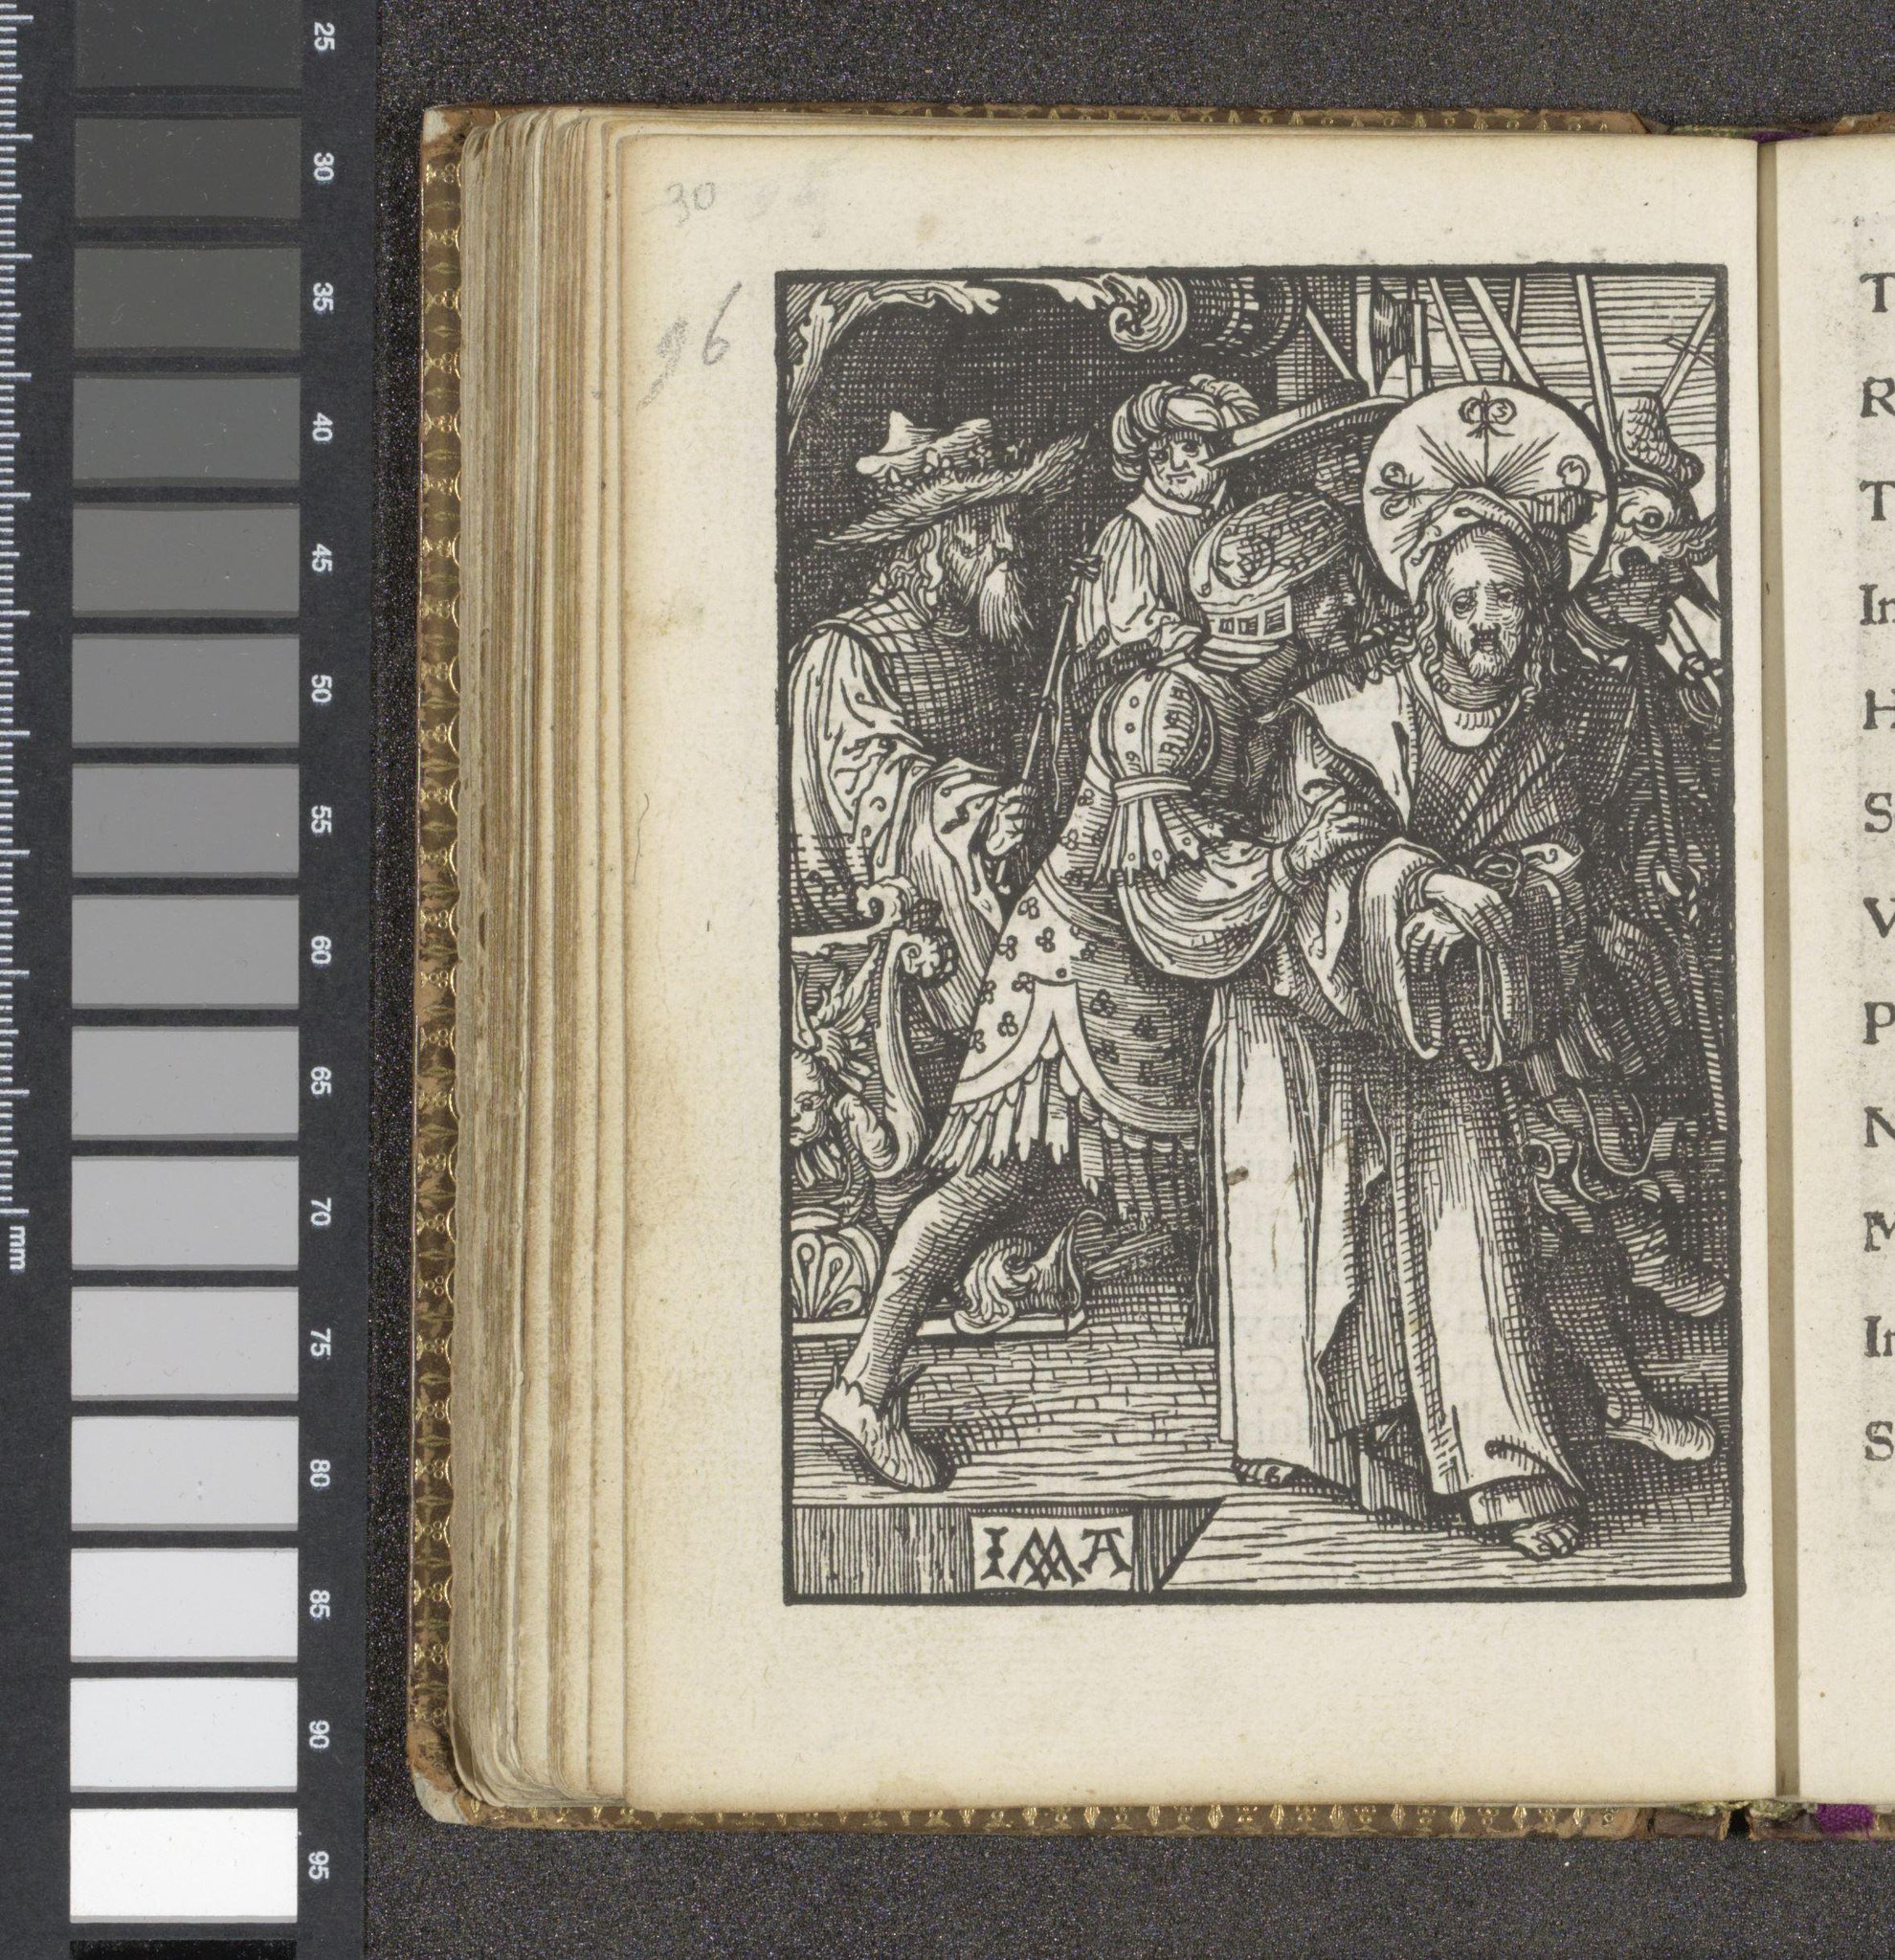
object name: book illustration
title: Christus weggeleid van Herodes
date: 1523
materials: paper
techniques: woodcut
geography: amsterdam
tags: christ before king herod; sometimes a gorgeous robe is brought (luke 23:8-11), christ brought from one judge to another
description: Soldaten leiden Christus weg van koning Herodes. Prent maakt deel uit van een boek.